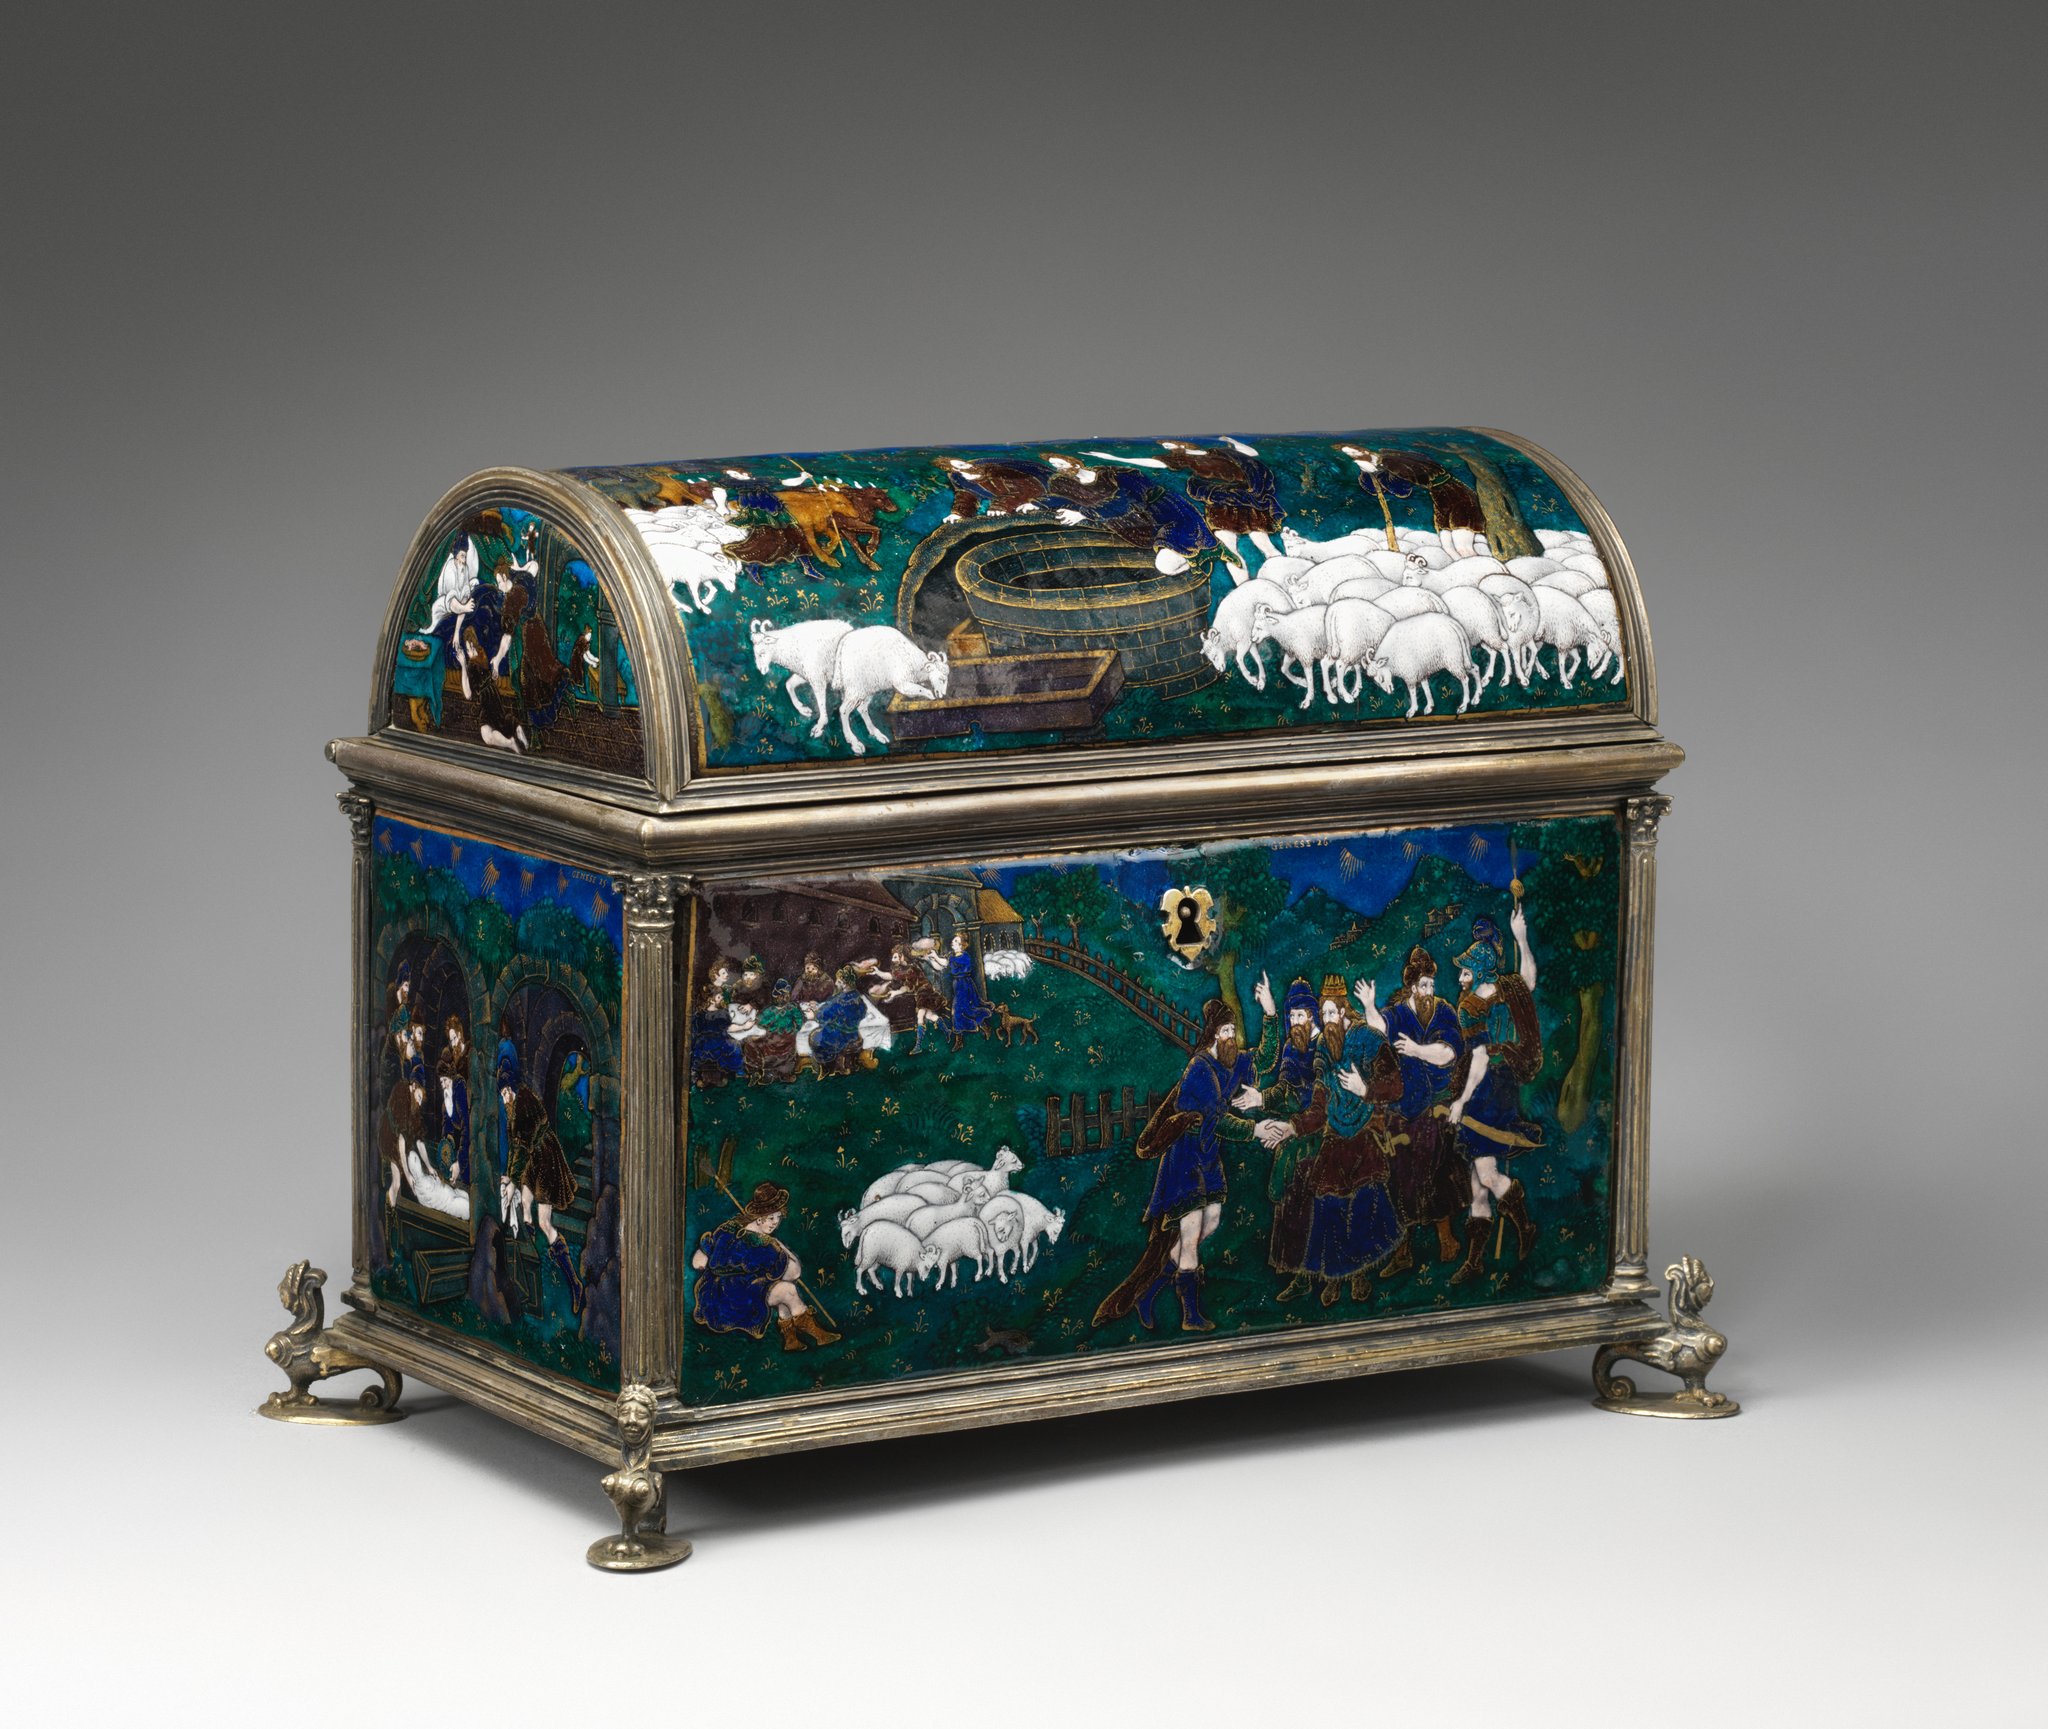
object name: casket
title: Casket with scenes of Genesis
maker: suzanne de court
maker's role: enameler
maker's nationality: french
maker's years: 1575-1625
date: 1601-1625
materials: copper, enamel, gilt, silver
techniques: painting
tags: wells,men,sheep,isaac,rebecca